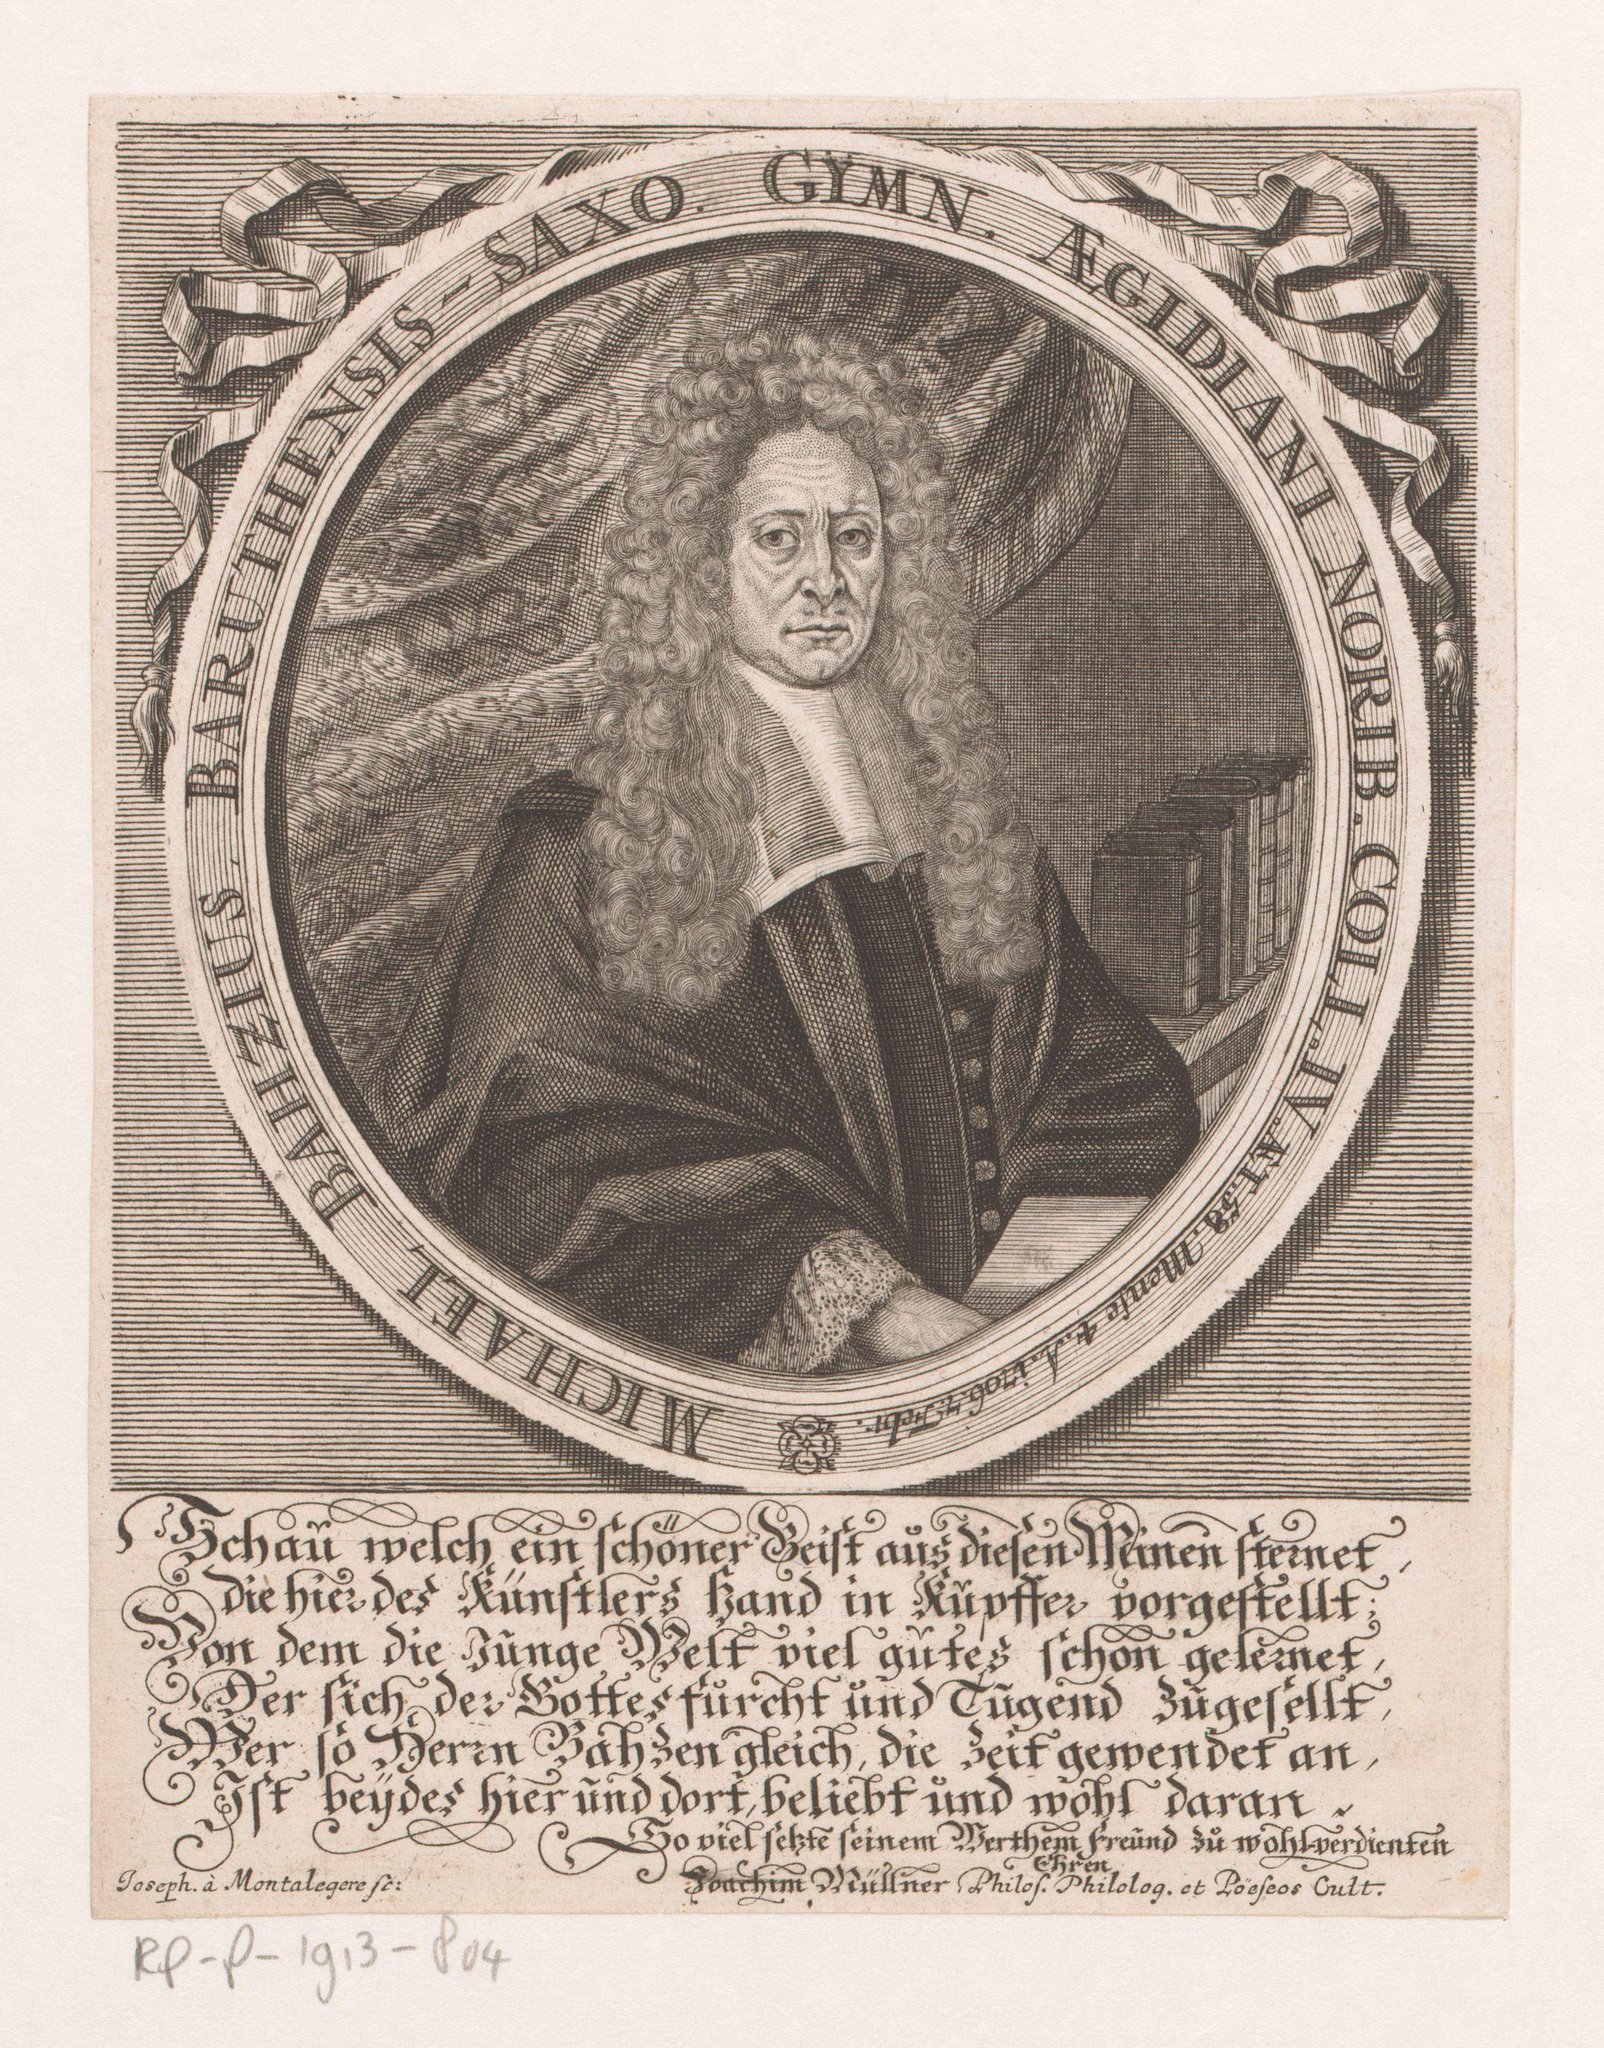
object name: print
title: Portret van Michael Bahz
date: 1700-1799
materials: paper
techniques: engraving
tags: bookshelves, historical persons, wig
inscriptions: collector's mark: Lugt 2228